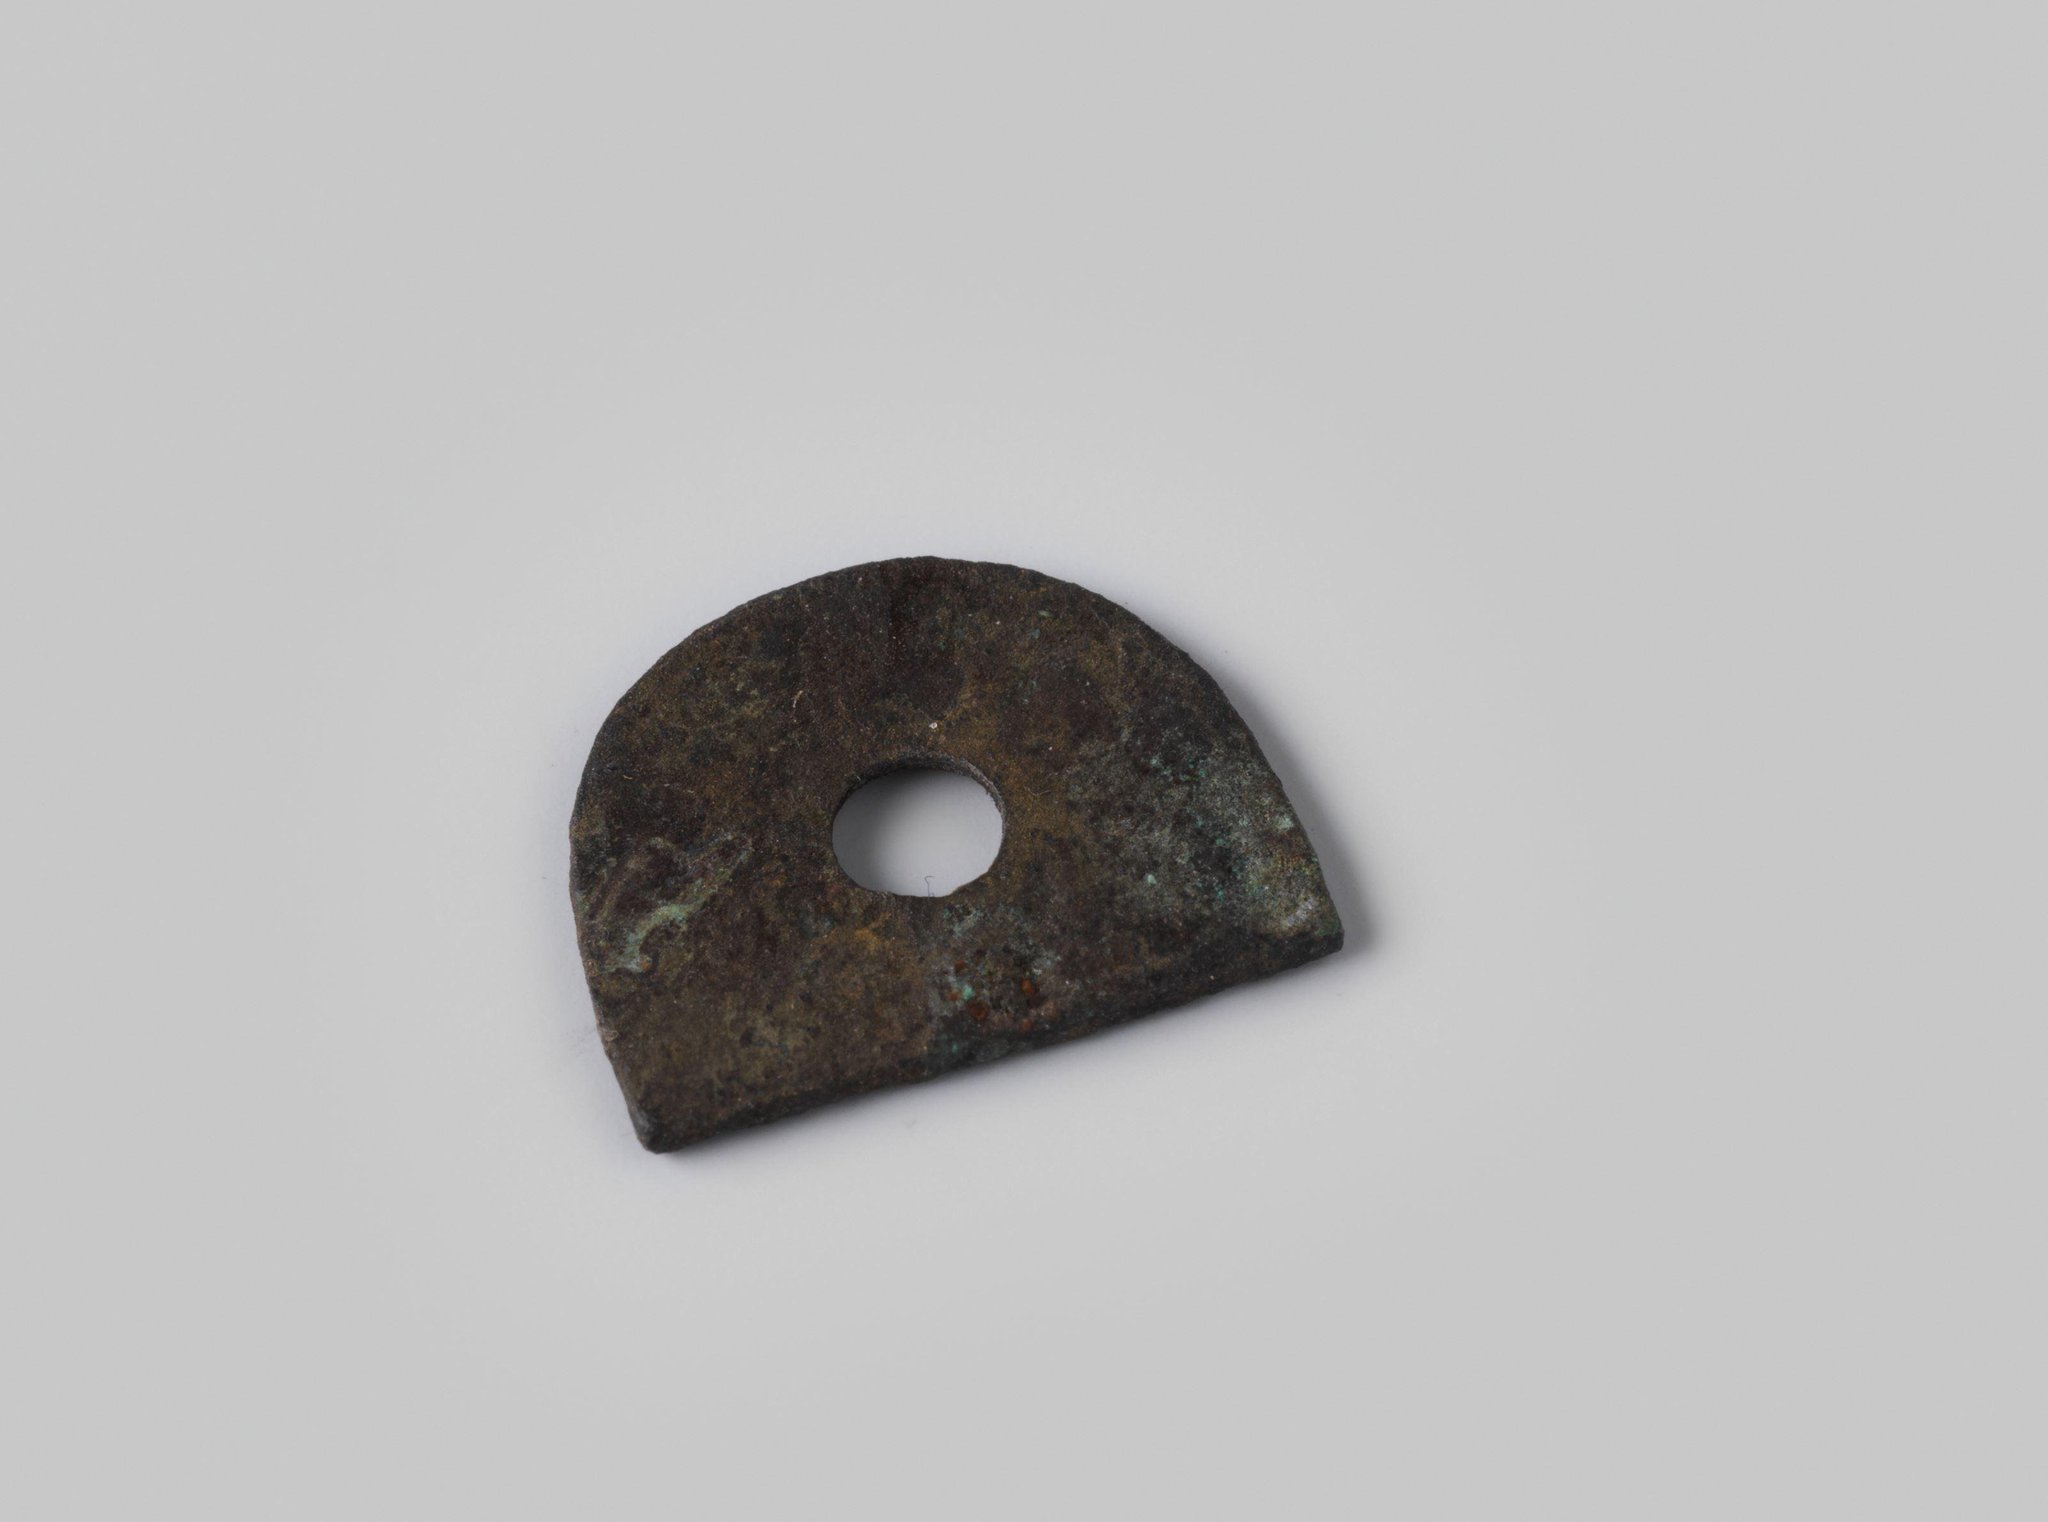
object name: fragment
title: Fragment van koper uit het wrak van de Oost-Indiëvaarder Hollandia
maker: Anonymous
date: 1700-1743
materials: copper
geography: netherlands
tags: verenigde oostindische compagnie, hollandia (schip), annet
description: Varied parts or fragments, strips and strip-shaped fragments; fragm.